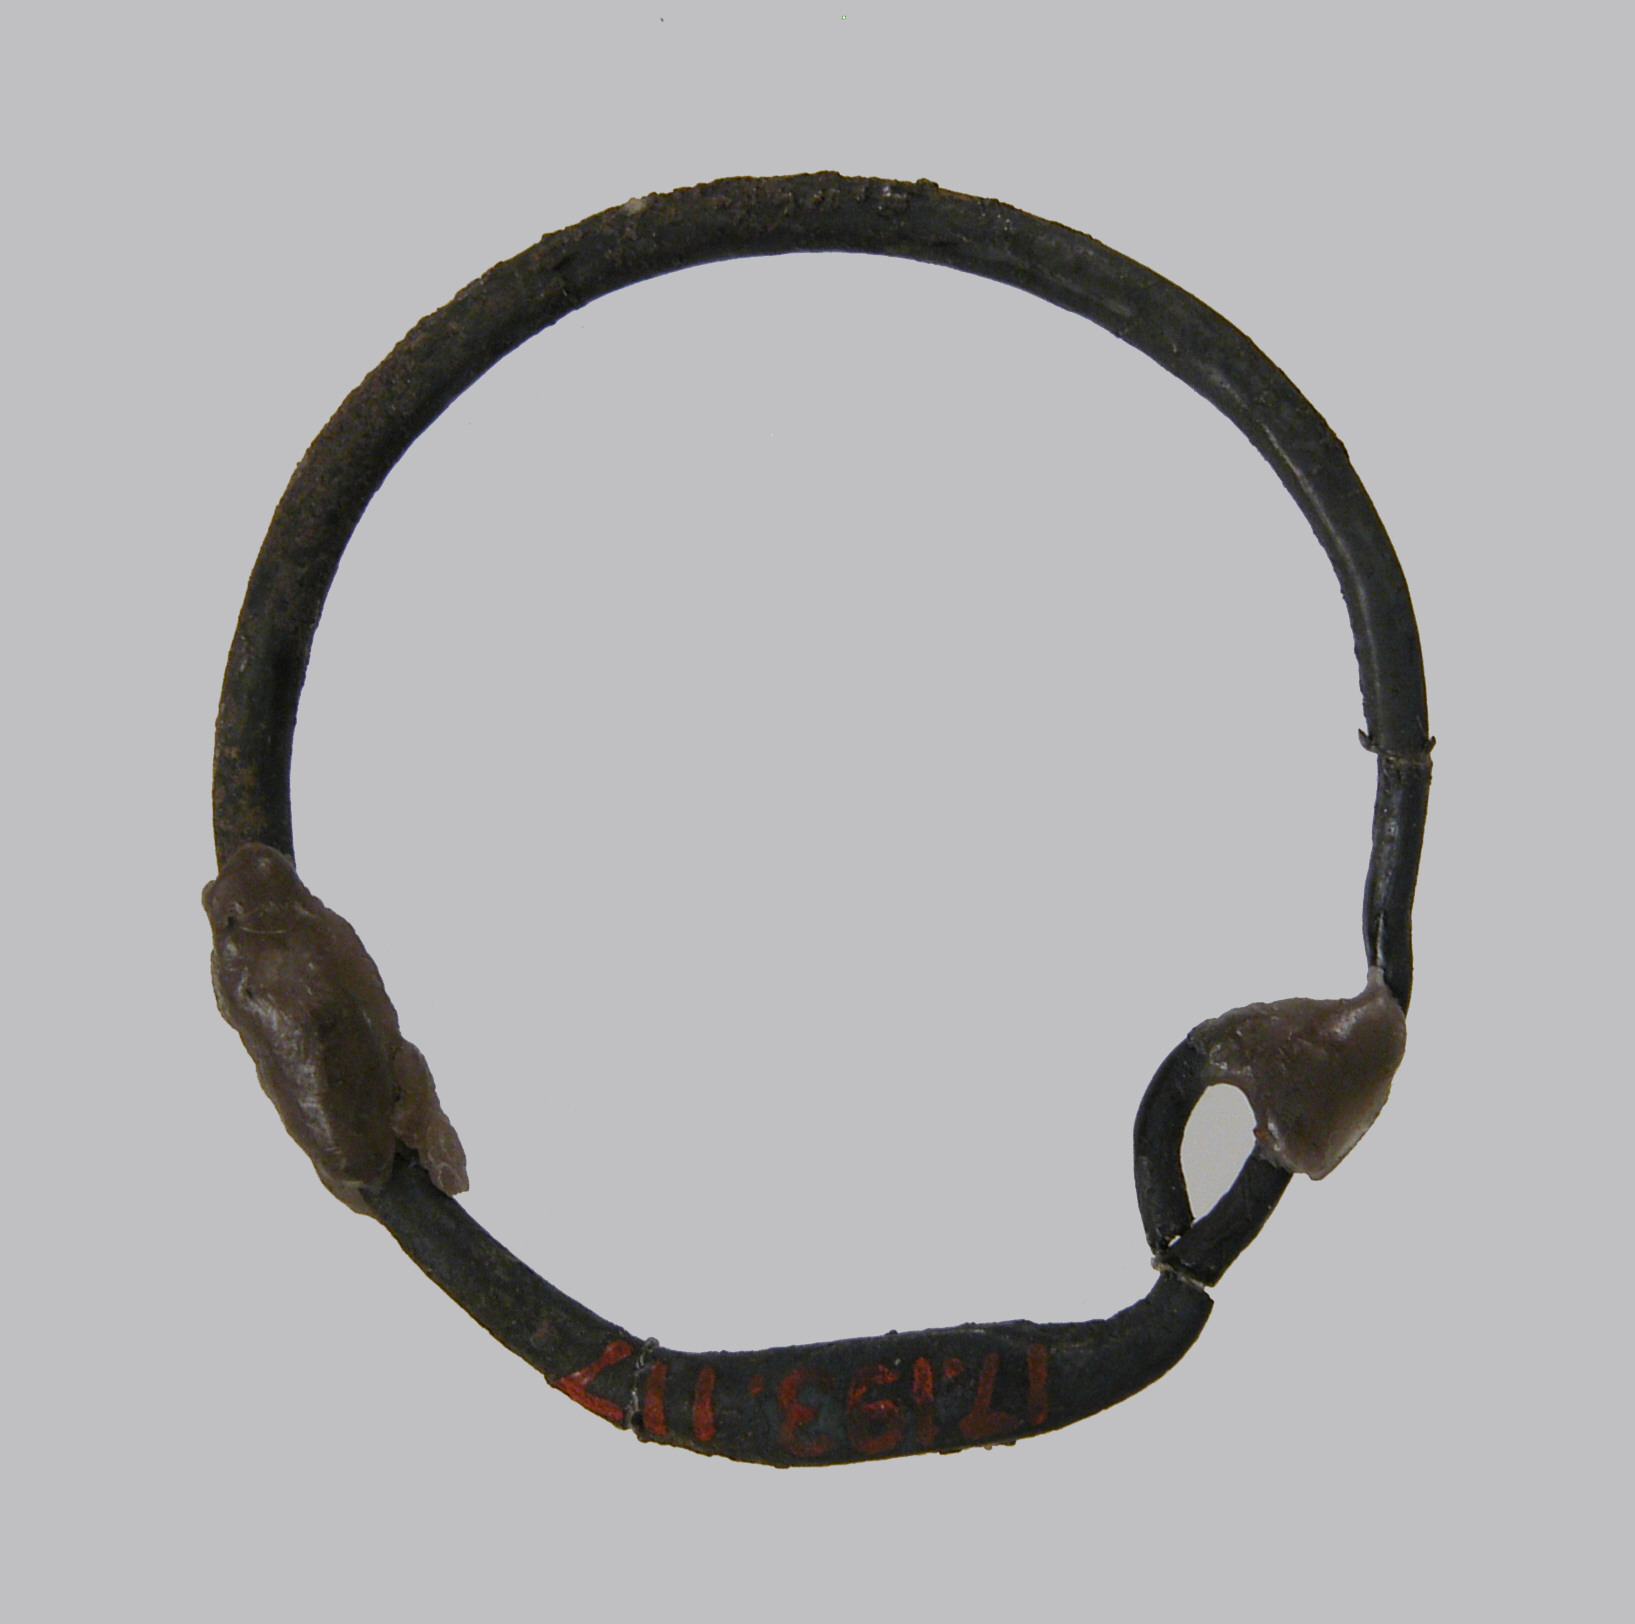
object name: earring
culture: frankish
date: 601-700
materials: silver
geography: germany